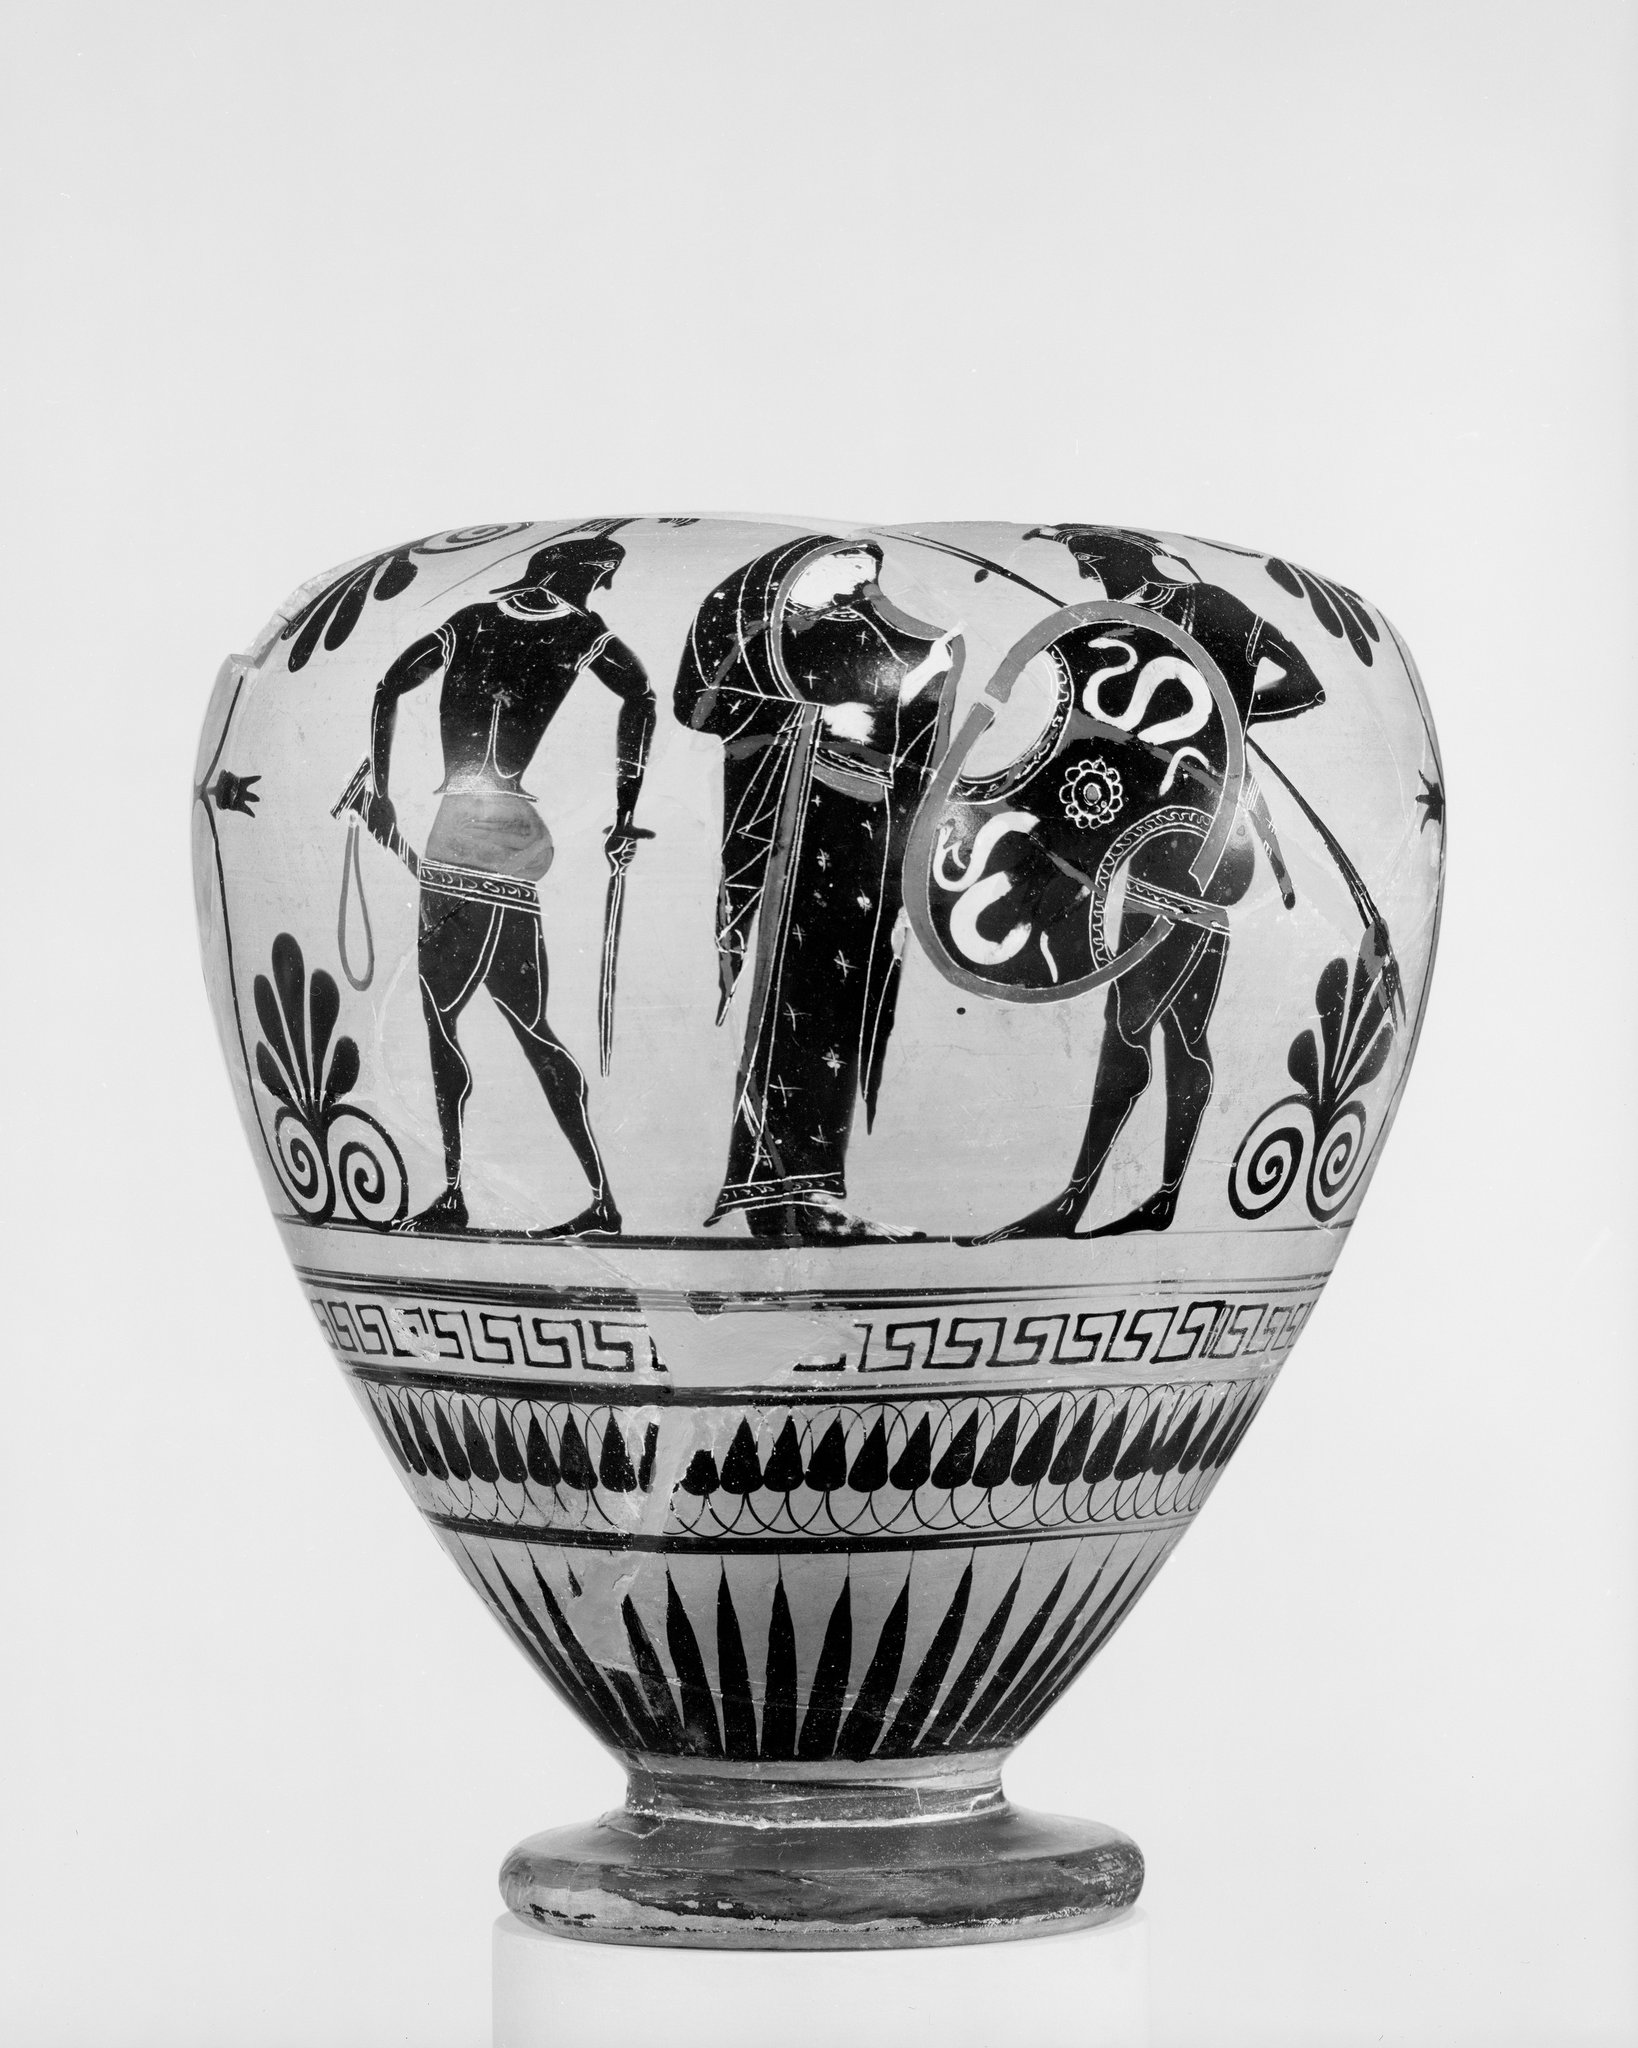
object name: neck amphora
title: Neck-amphora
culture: greek, attic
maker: antimenes painter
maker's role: artist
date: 520 BCE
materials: terracotta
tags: shields,men,women,centaurs